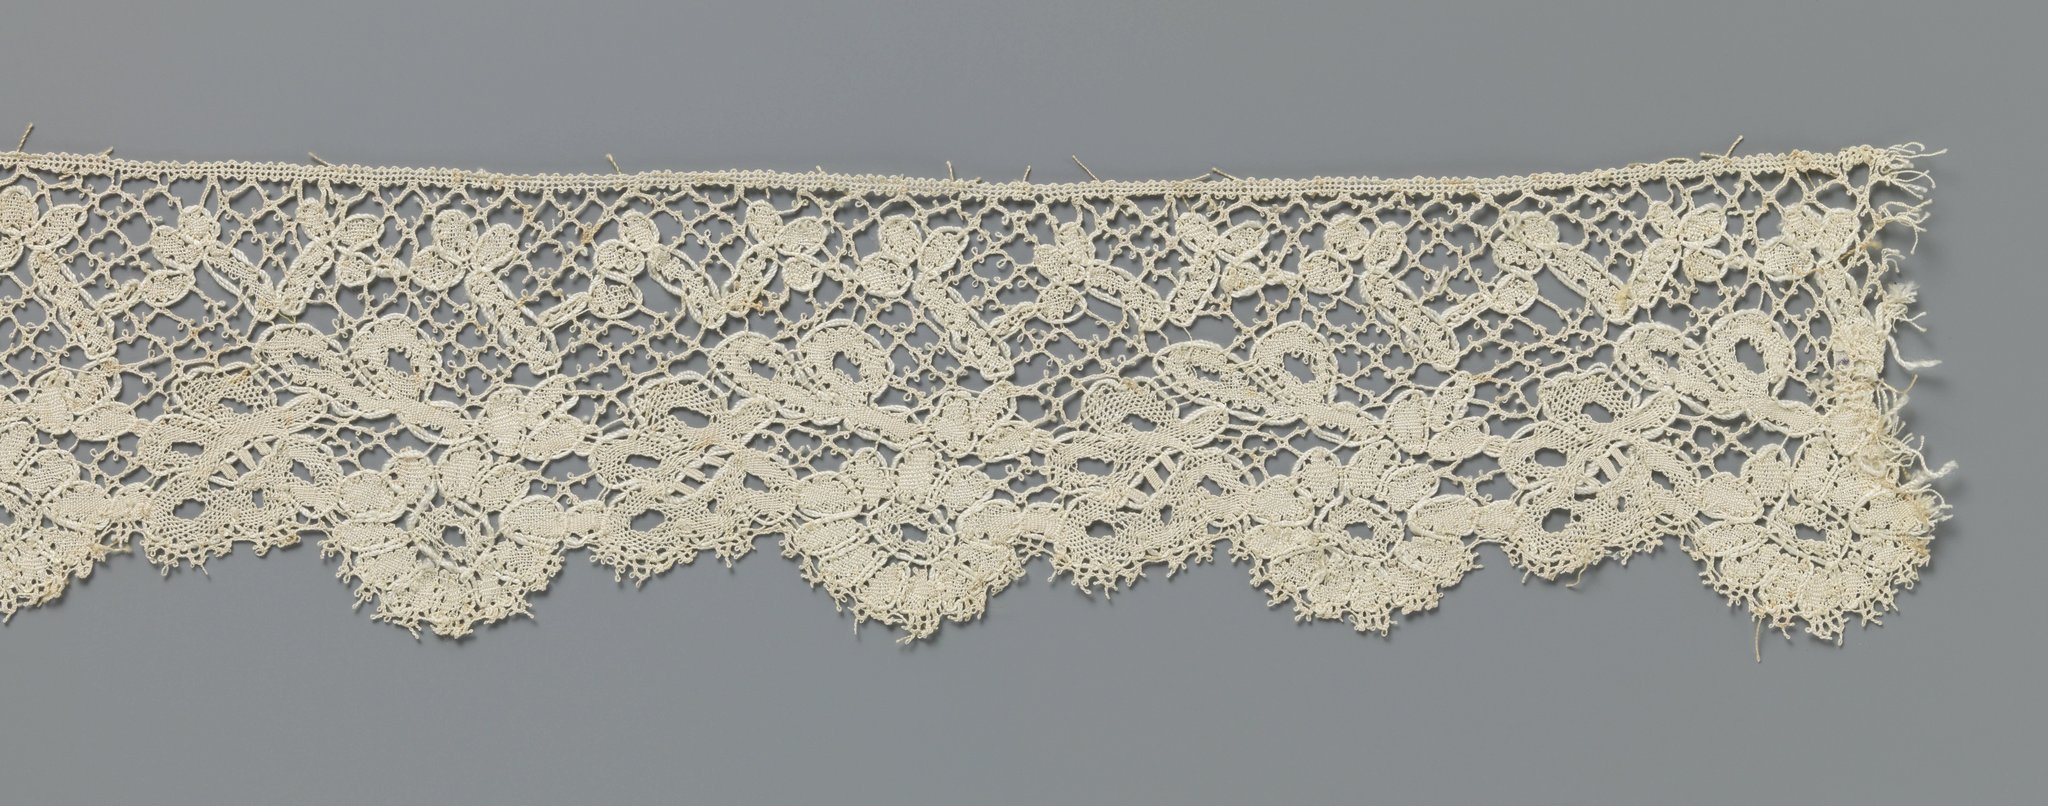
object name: strip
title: Strook kloskant met schulpenrand van afwisselend een rozetbloem en een vijflobbig blad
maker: Anonymous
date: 1800-1899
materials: silk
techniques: lace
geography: france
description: Strook naturelkleurige kloskant, Cluny-kant. Het zich herhalende patroon bestaat langs de onderzijde van strook uit een rozetbloem en een schuin geplaatst vijflobbig blad. De opeenvolgende bloemen en bladeren zijn tegen elkaar geplaatst en vormen samen een schulpenrand. Boven de middenlijn is een soort zigzag-lijn gecreeërd met schuin tegen elkaar geplaatste langwerpige motiefjes, elk bekroond door drie ovale motiefjes. De motieven zijn gemaakt in losgewerkte linnenslag met dubbele contourdraden. Ze zijn met elkaar verbonden door een ruitvormige maasgrond, gevormd door gepicoteerde vlechtjes. In het centrum van het vijflobbig blad staan blokjes gemaakt in vormslag. De bovenzijde van de strook is recht afgewerkt. De schulpenrand langs de onderzijde komt voort uit het patroon en is afgewerkt met kleine boogjes gemaakt met vlechtjes, voorzien van picots.